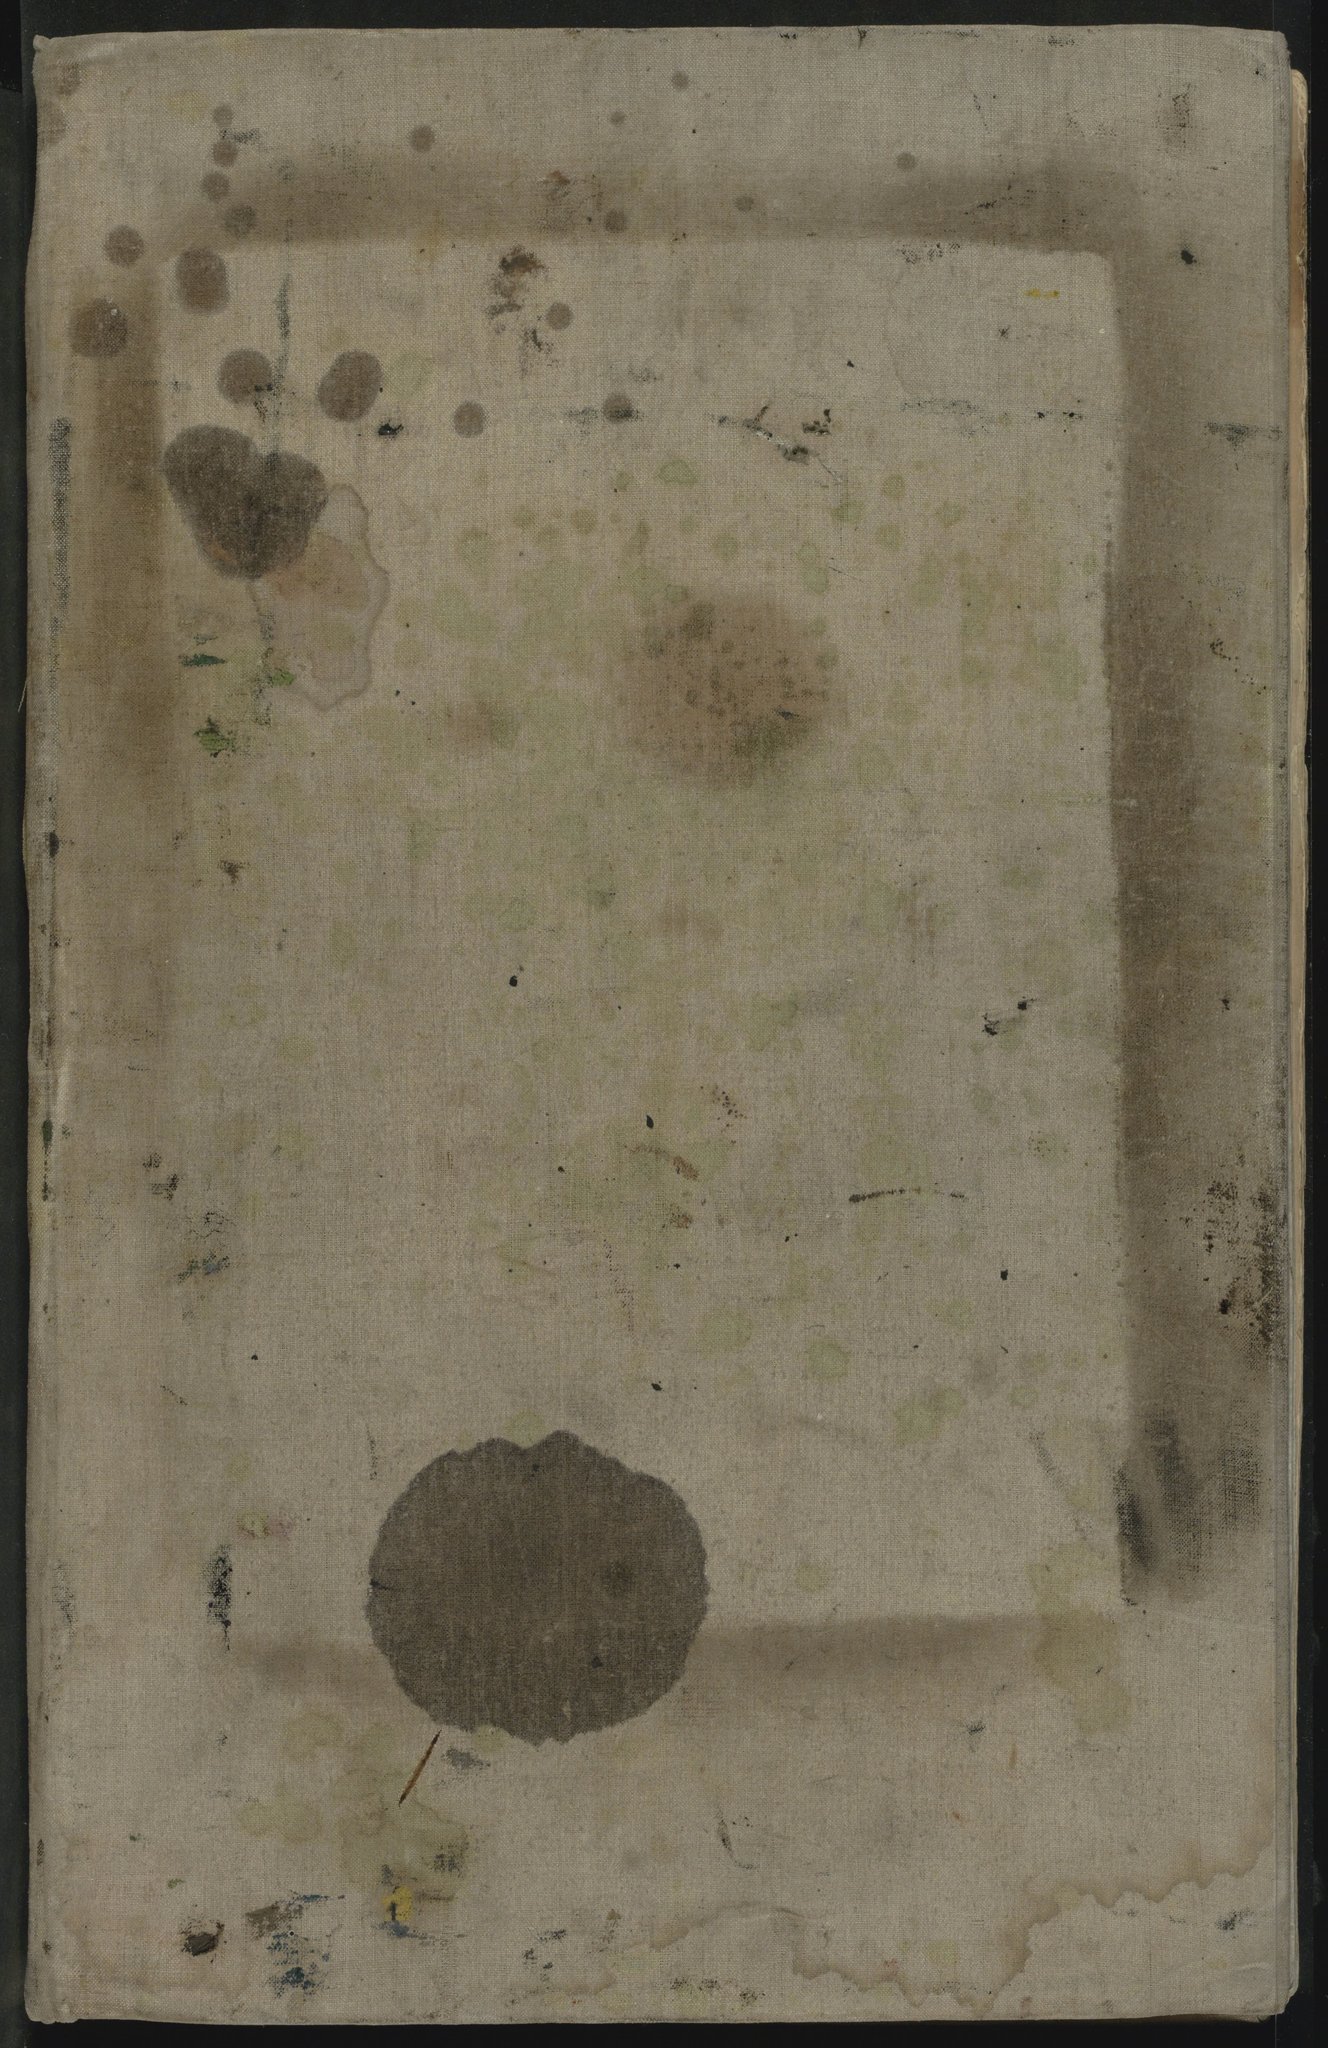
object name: sketchbook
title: Schetsboek met 42 bladen vervaardigd rond de Ewijkshoeve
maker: willem witsen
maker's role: draughtsman, painter, print maker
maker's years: 1860-1923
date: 1884-1887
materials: cardboard, chalk, linen, paper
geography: ewijkshoeve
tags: woodgathering, woodgatherer, farmers, cattle driving, cattle driver, forest, wood, sheep, stall, stable, farm (building)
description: Schetsboek bestaande uit 42 bladen met landschappen rond de Ewijkshoeve, schaapherders, boeren, schaapskooien en boerderijen.